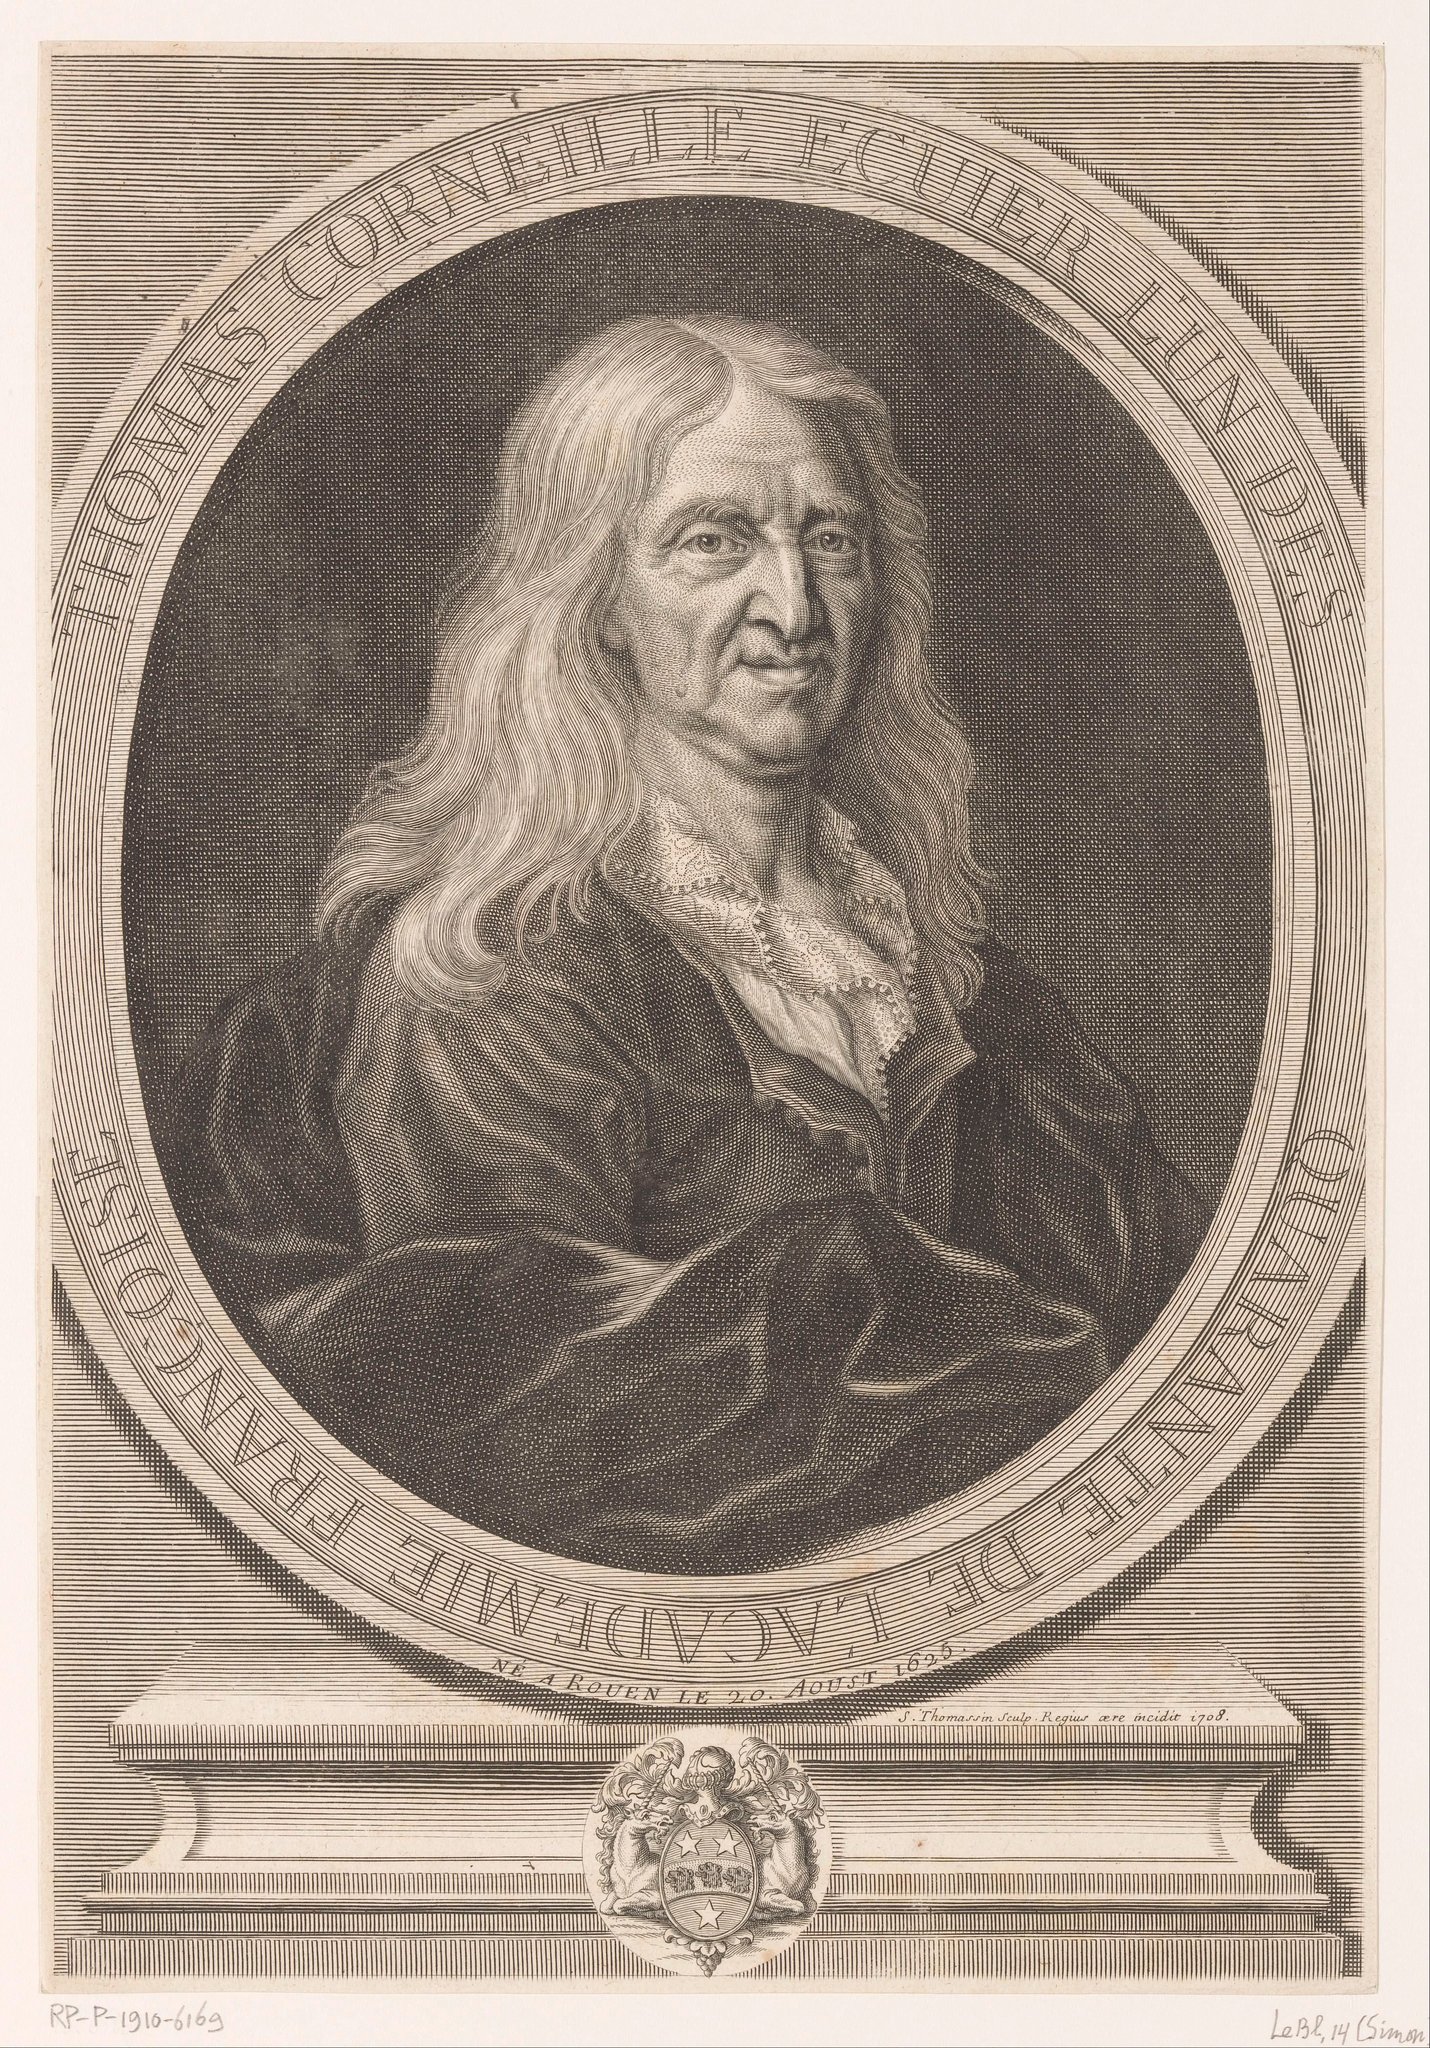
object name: print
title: Portret van Thomas Corneille in ovale lijst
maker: simon thomassin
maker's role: print maker, publisher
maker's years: 1655-1733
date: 1708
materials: paper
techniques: engraving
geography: france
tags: director, producer ~ the stage, historical persons, writer, poet, author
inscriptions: collector's mark: Lugt 2228